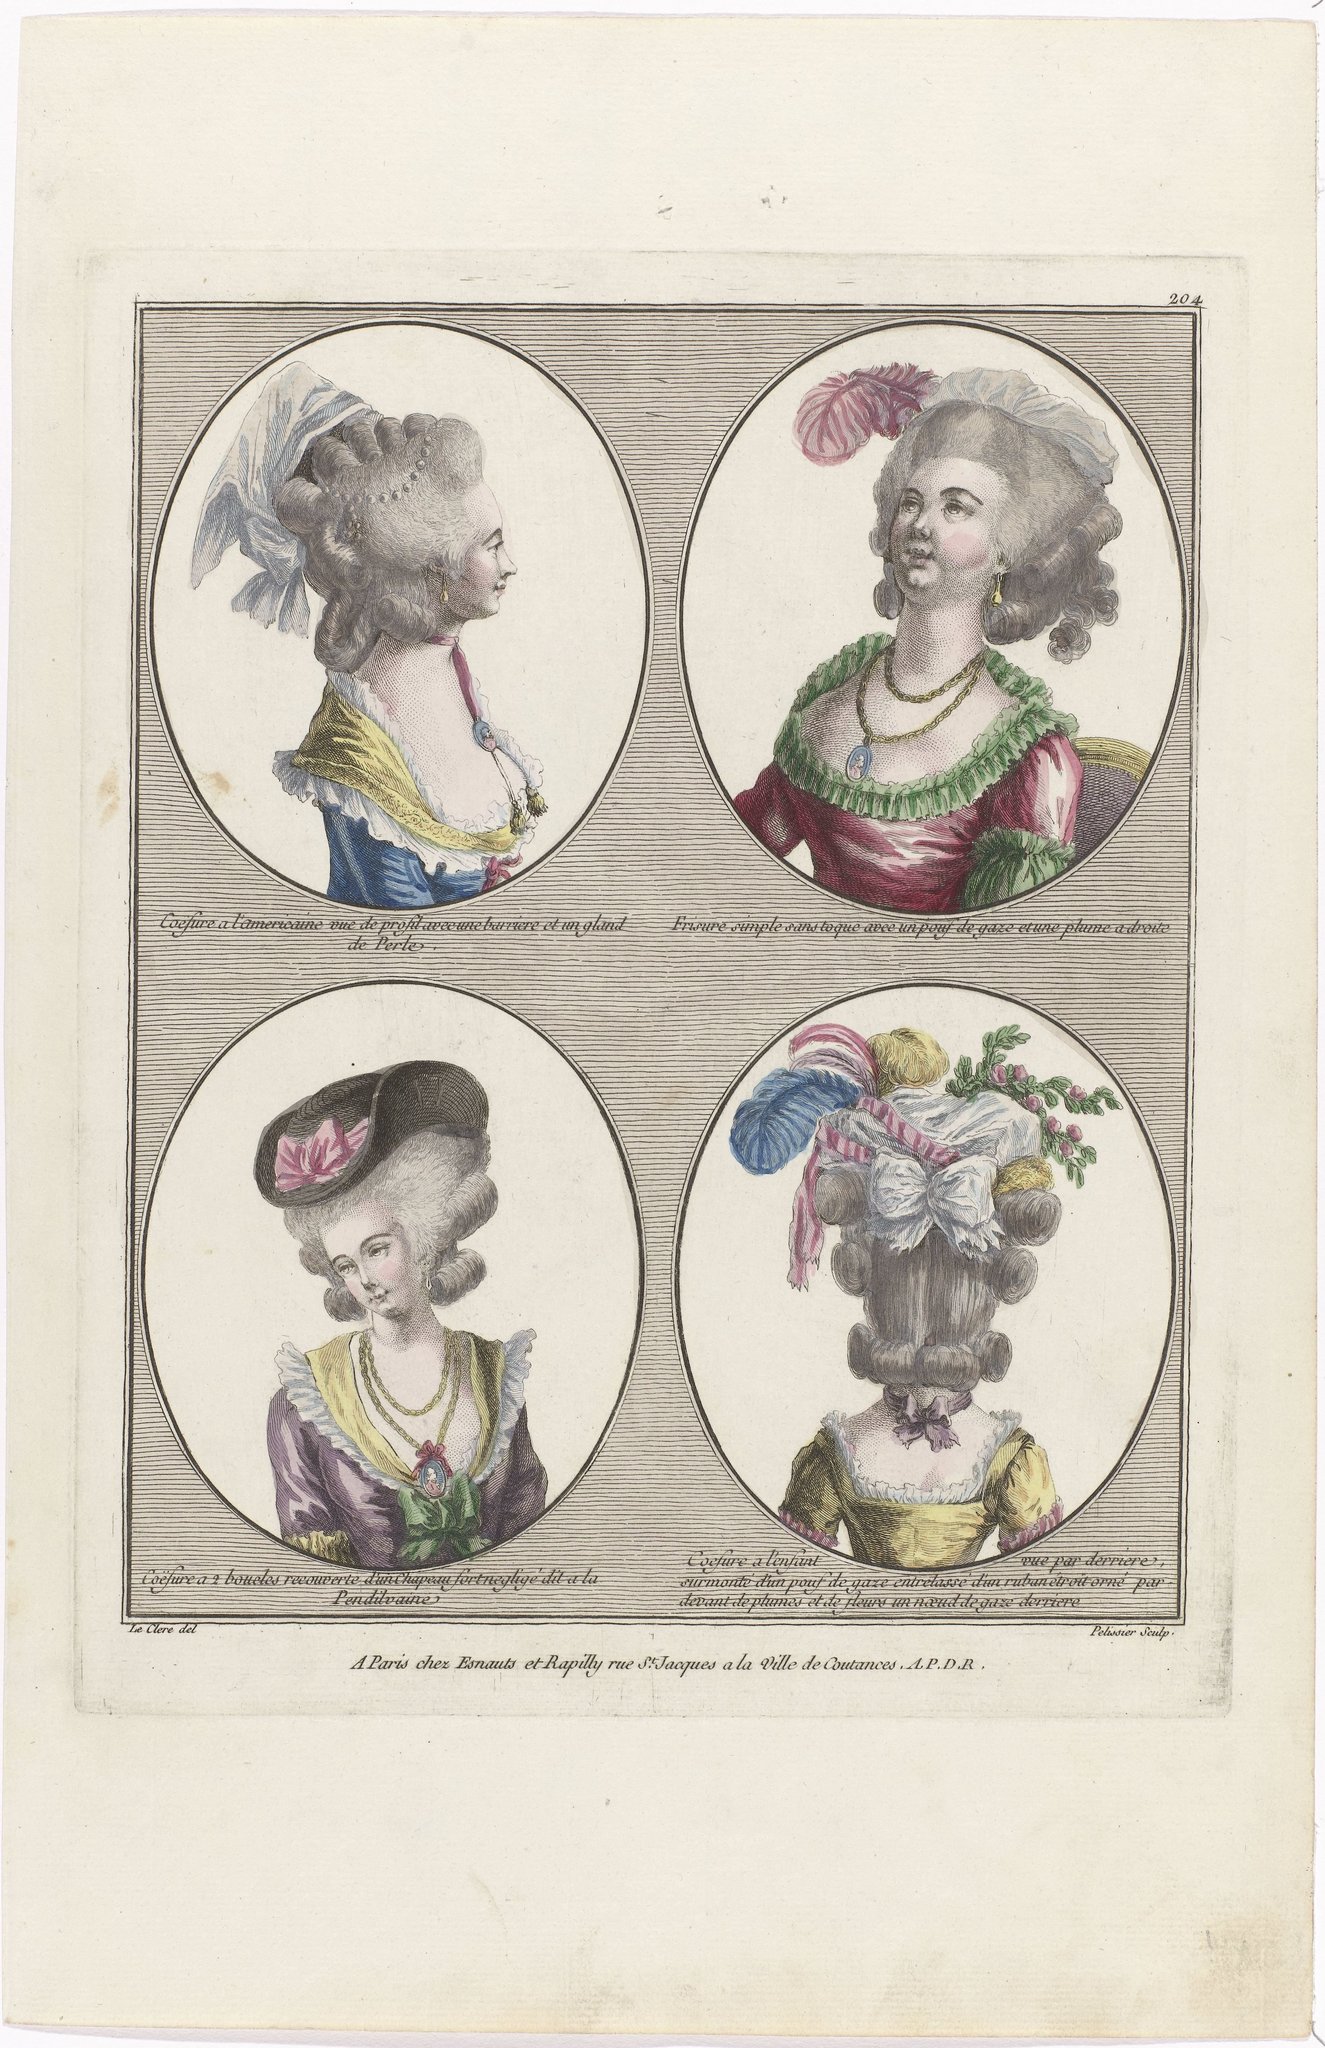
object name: fashion print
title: Coiffures, Poufs, Hats and Bonnets: Eleven Coiffures and Headdresses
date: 1780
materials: paper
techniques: engraving, hand coloring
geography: paris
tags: ear-rings (+ women's clothes), head-gear (pouf) (+ women's clothes), border, ribbon, braid (+ women's clothes), styles of hairdress - aa - ~ women, fashion plates, head-gear: hat (+ women's clothes), necklace (+ women's clothes), pearl; pearl necklace (+ women's clothes)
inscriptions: inscription: ‘Coefure a l'Americaine vue de profil avec une barriere et un gland de perle.’, inscription: ‘Coefure a l'enfant vue par derriere surmonté d'un pouf de gaze entrelasse d'un ruban étroit orné par devant de plumes et de fleurs un noeud de gaze derriere.’, address: ‘A Paris chez Esnauts et Rapilly rue St. Jacques a la Ville de Coutances. A.P.D.R.’, inscription: ‘Frisure simple sans toque avec un pouf de gaze et une plume a droite’, inscription: ‘Coëfure a 2 boucles recouverte d'un Chapeau fortnegligé dit a la Pendilvaine.’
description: Ladies’ hairstyles were ingenious works of art, built around a core of cushions and horsehair. Hair was piled high in curls and twists (chignons) and adorned with feathers, ribbons, artificial flowers, tulle and jewels to create various fancifully named poufs. Because the hair was dressed using animal fat and powdered with wheat flour, these poufs attracted all manner of insects. Far from hygienic, they moreover did not last long. When they went out, ladies protected their hairdos with a voluminous ribbed hood called a calèche 1. Hairdressers of the time, who styled themselves as artists, used prints to advertise their latest creations and craftsmanship 2 3.